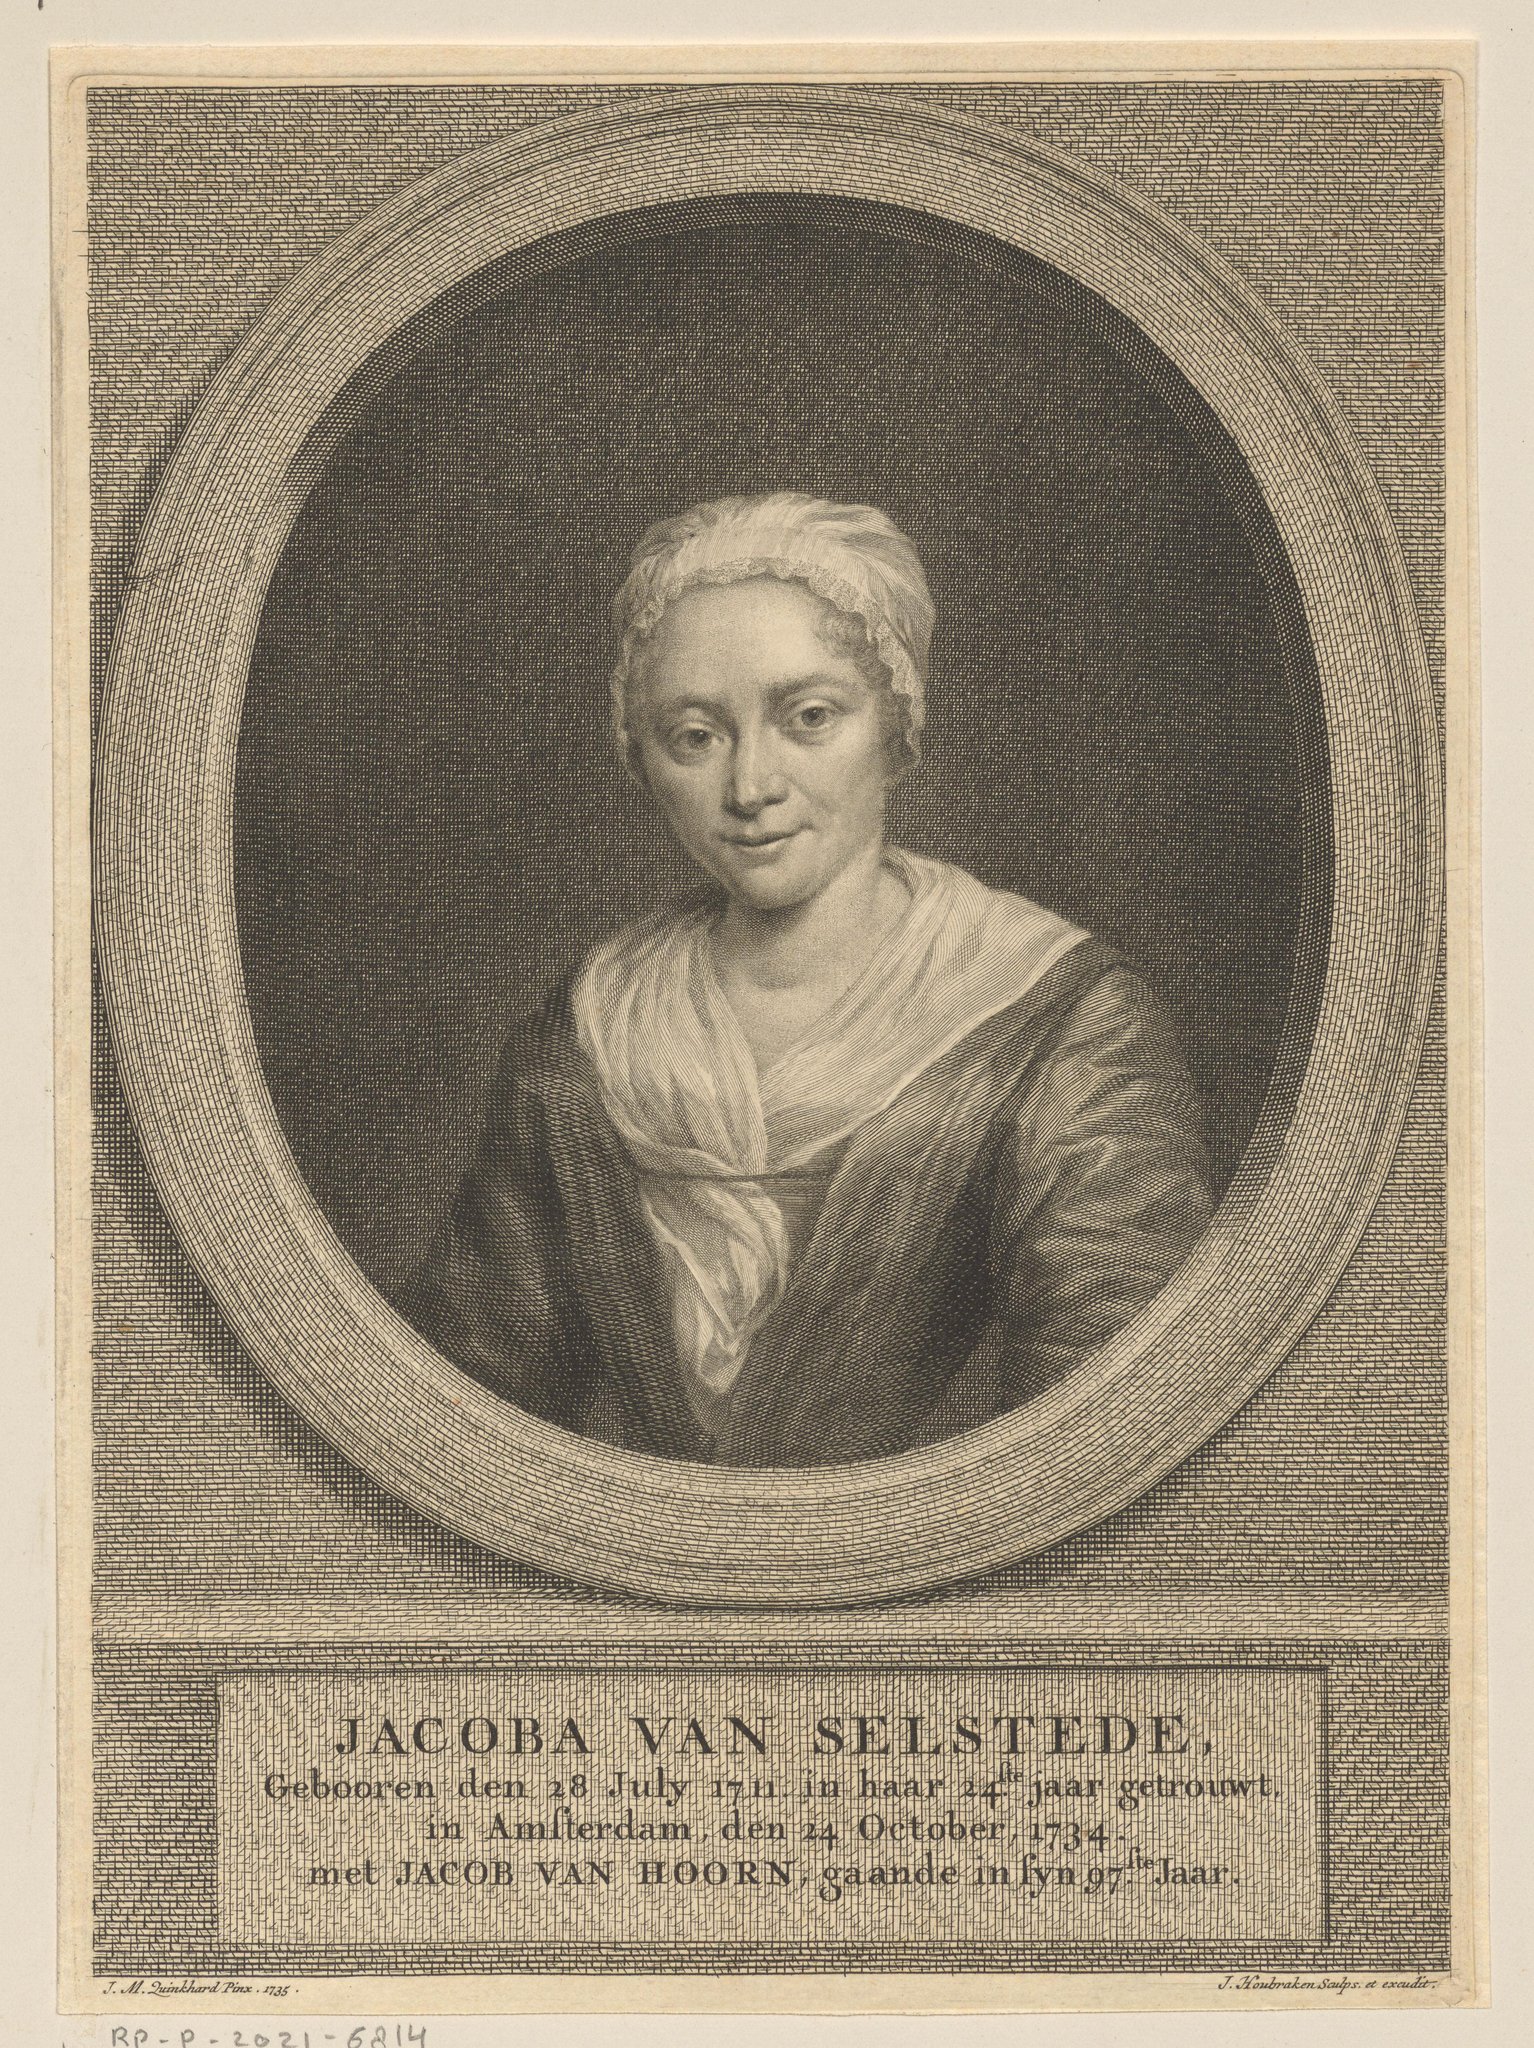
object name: print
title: Portret van Jacoba van Selstede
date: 1735-1736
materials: paper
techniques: engraving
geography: amsterdam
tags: historical persons - bb - woman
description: Pendant van het portret van Jacob van Hoorn.